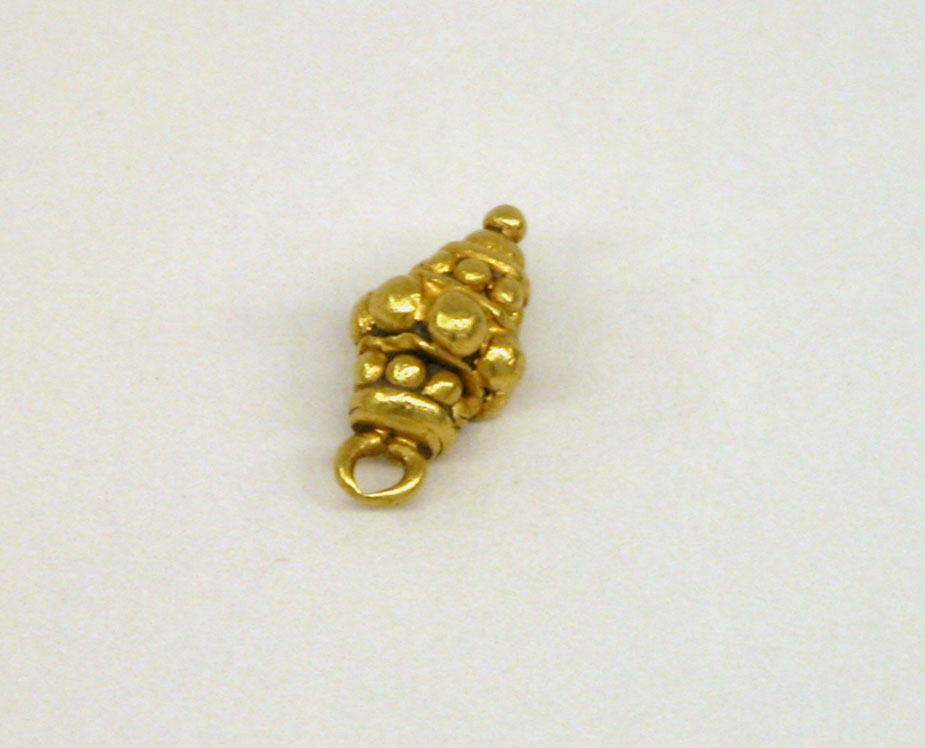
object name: pendant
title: Pendant Composed of Granulate Motifs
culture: indonesian, javanese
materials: gold